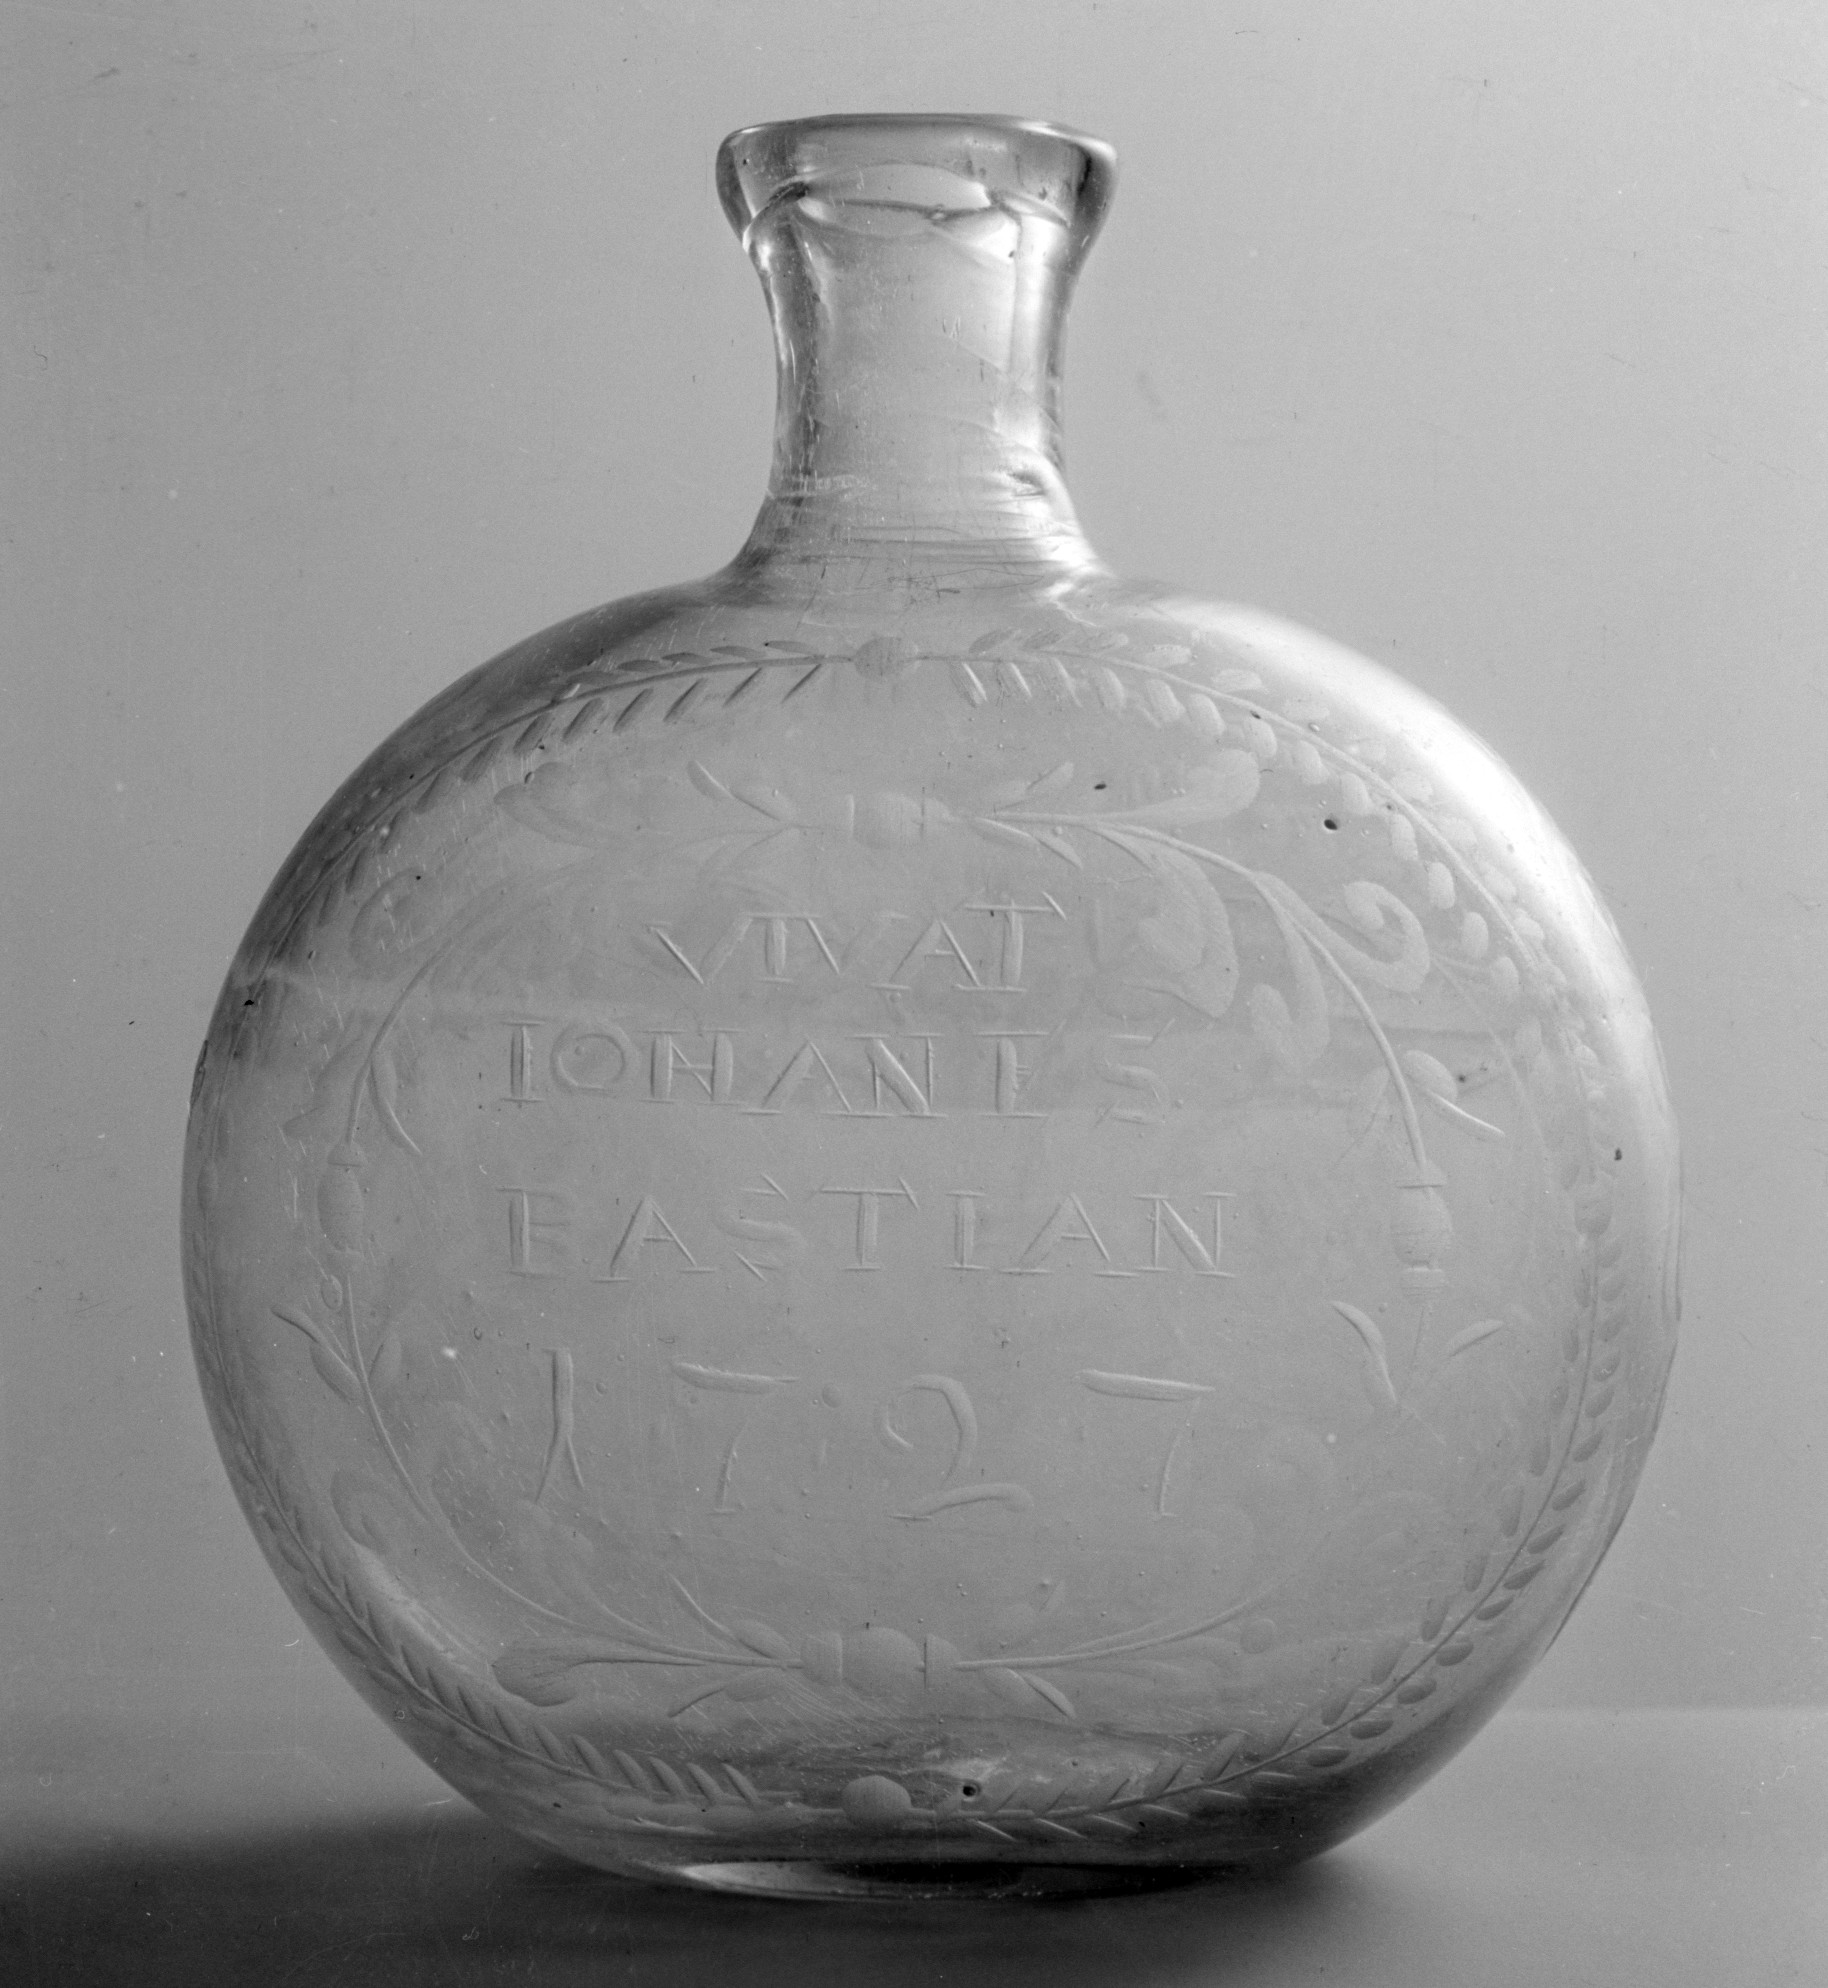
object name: bottle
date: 1727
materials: glass